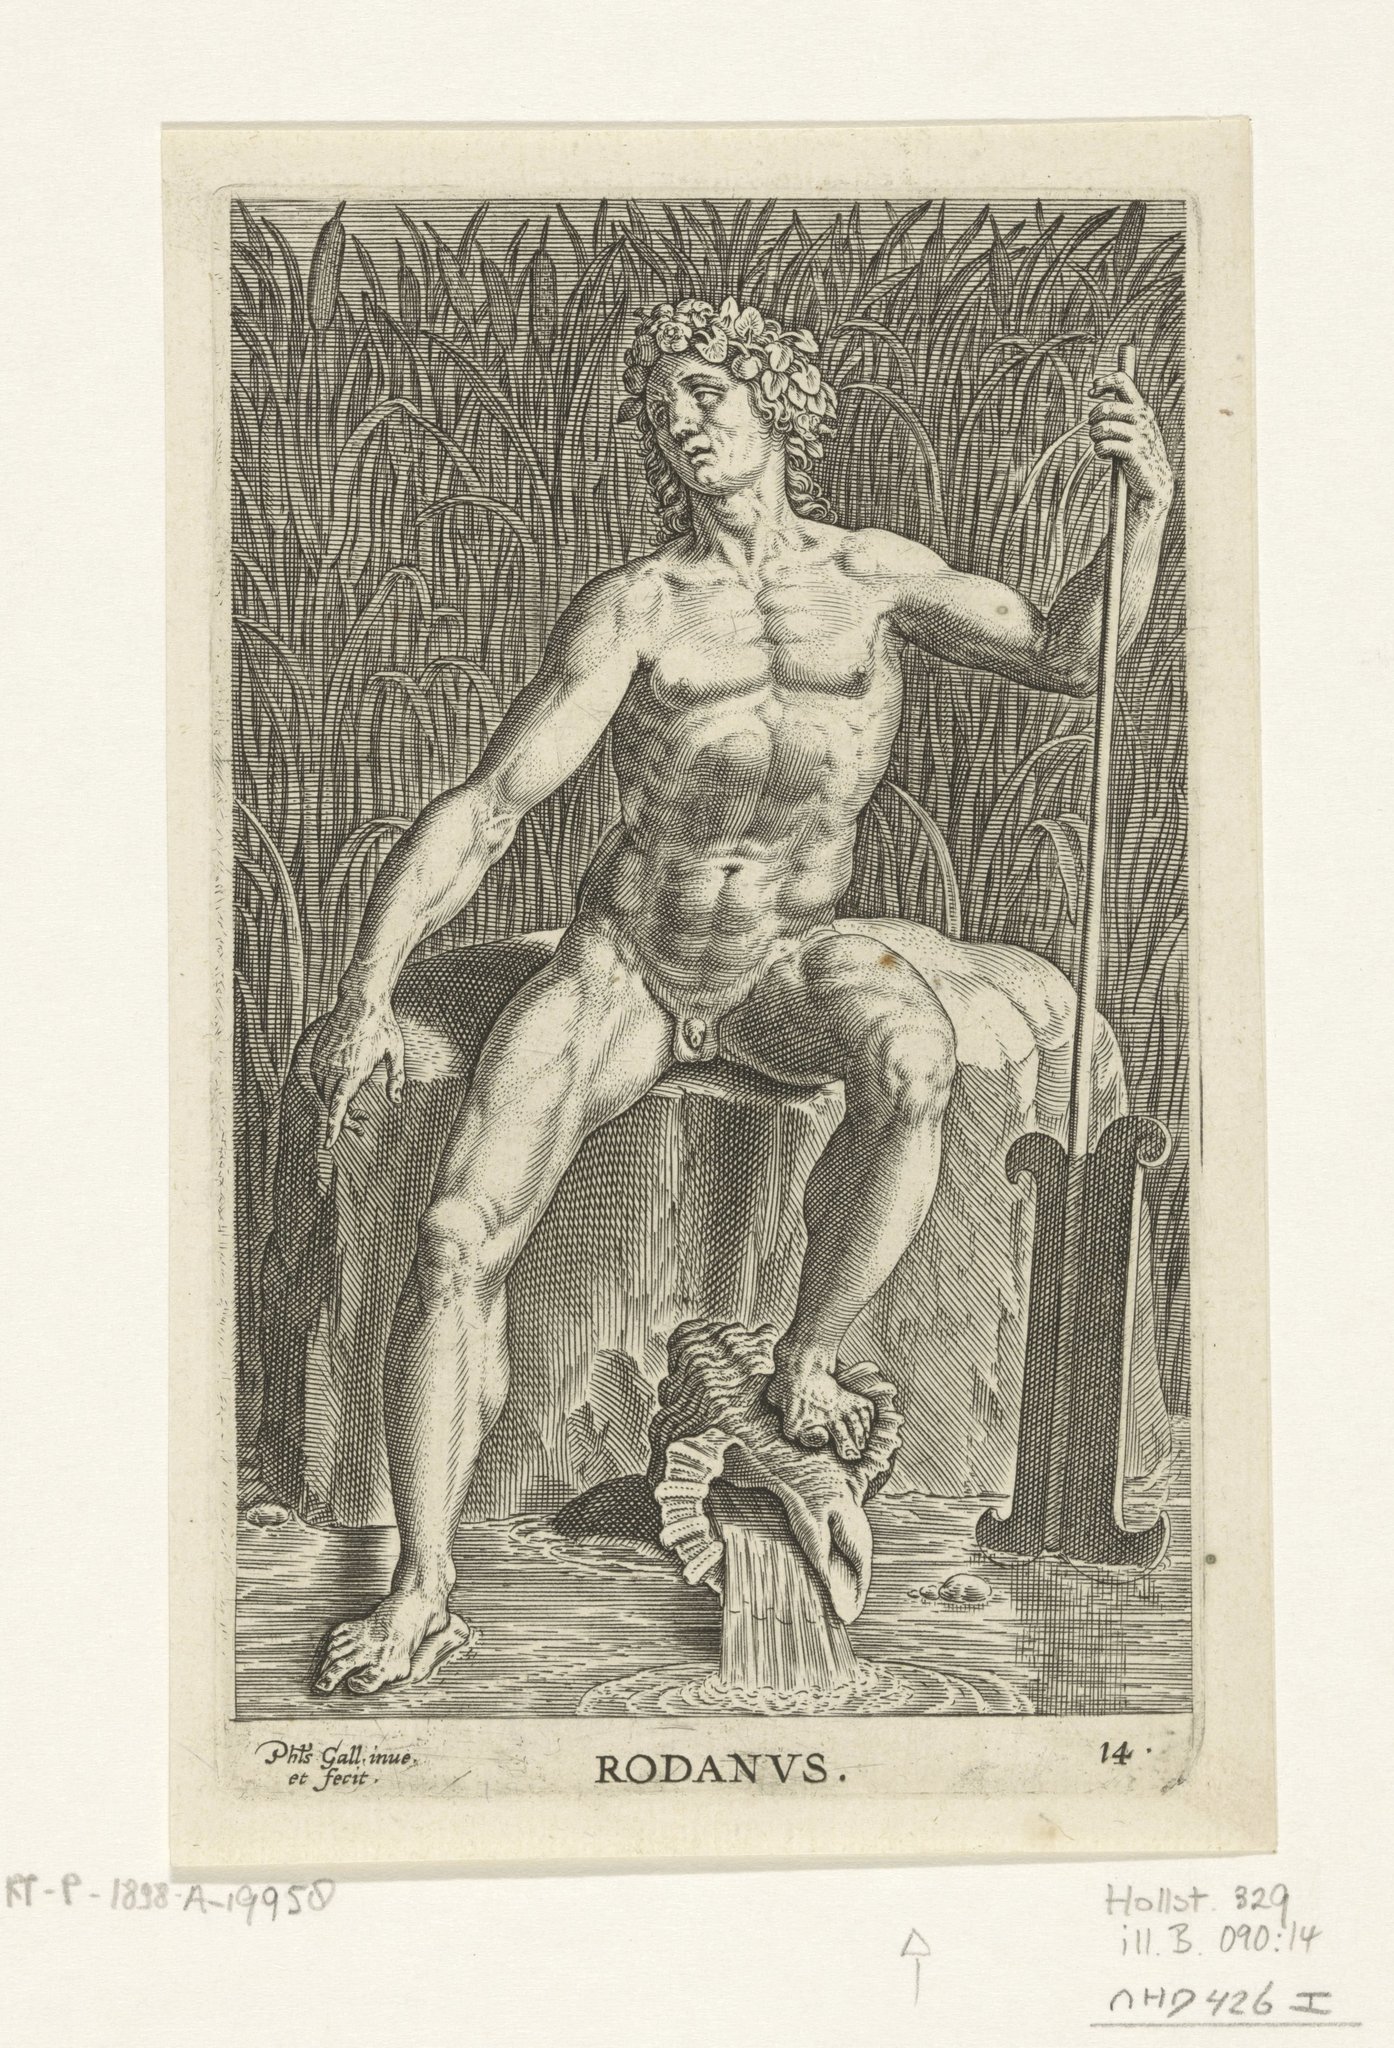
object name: print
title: Rodanvs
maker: philips galle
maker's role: print maker, publisher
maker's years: 1537-1612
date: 1586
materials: paper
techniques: engraving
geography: antwerp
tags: river personified (rhone)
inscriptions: collector's mark: Lugt 2228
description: De riviergod Rodanus (de Rhone), gezeten op een stenen blok. De prent maakt deel uit van een zeventiendelige serie over rivier- en zeegoden.